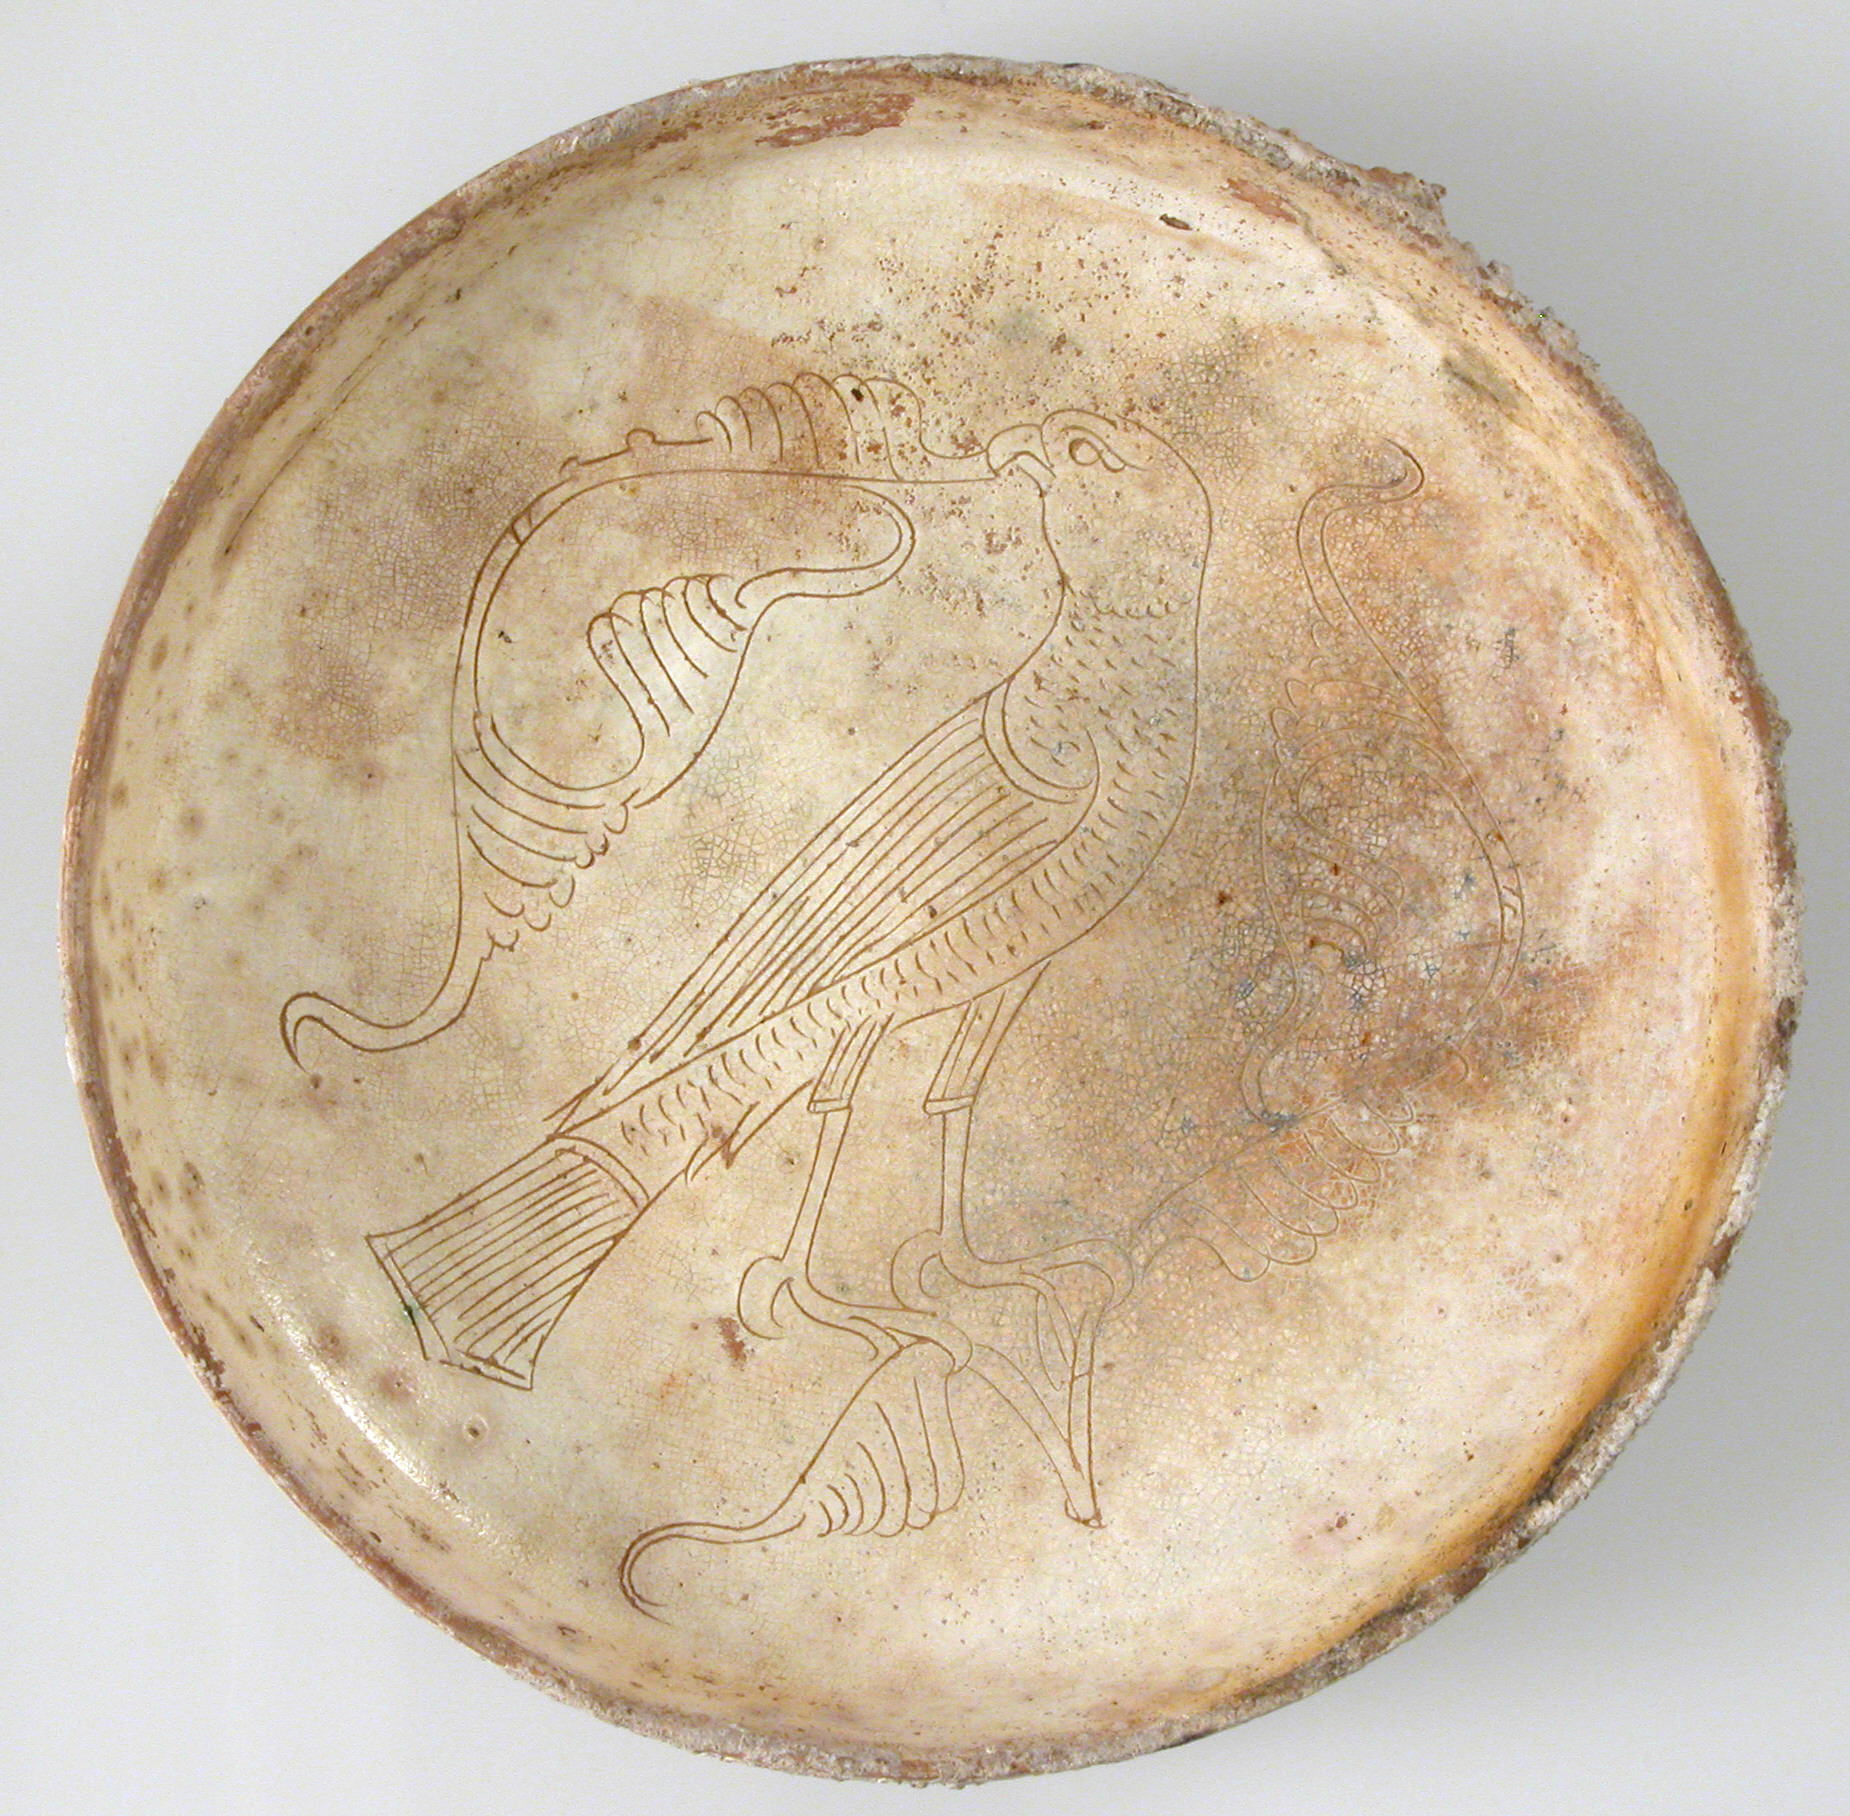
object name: bowl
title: Bowl with Bird of Prey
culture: byzantine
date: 1001-1300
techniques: engraving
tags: birds